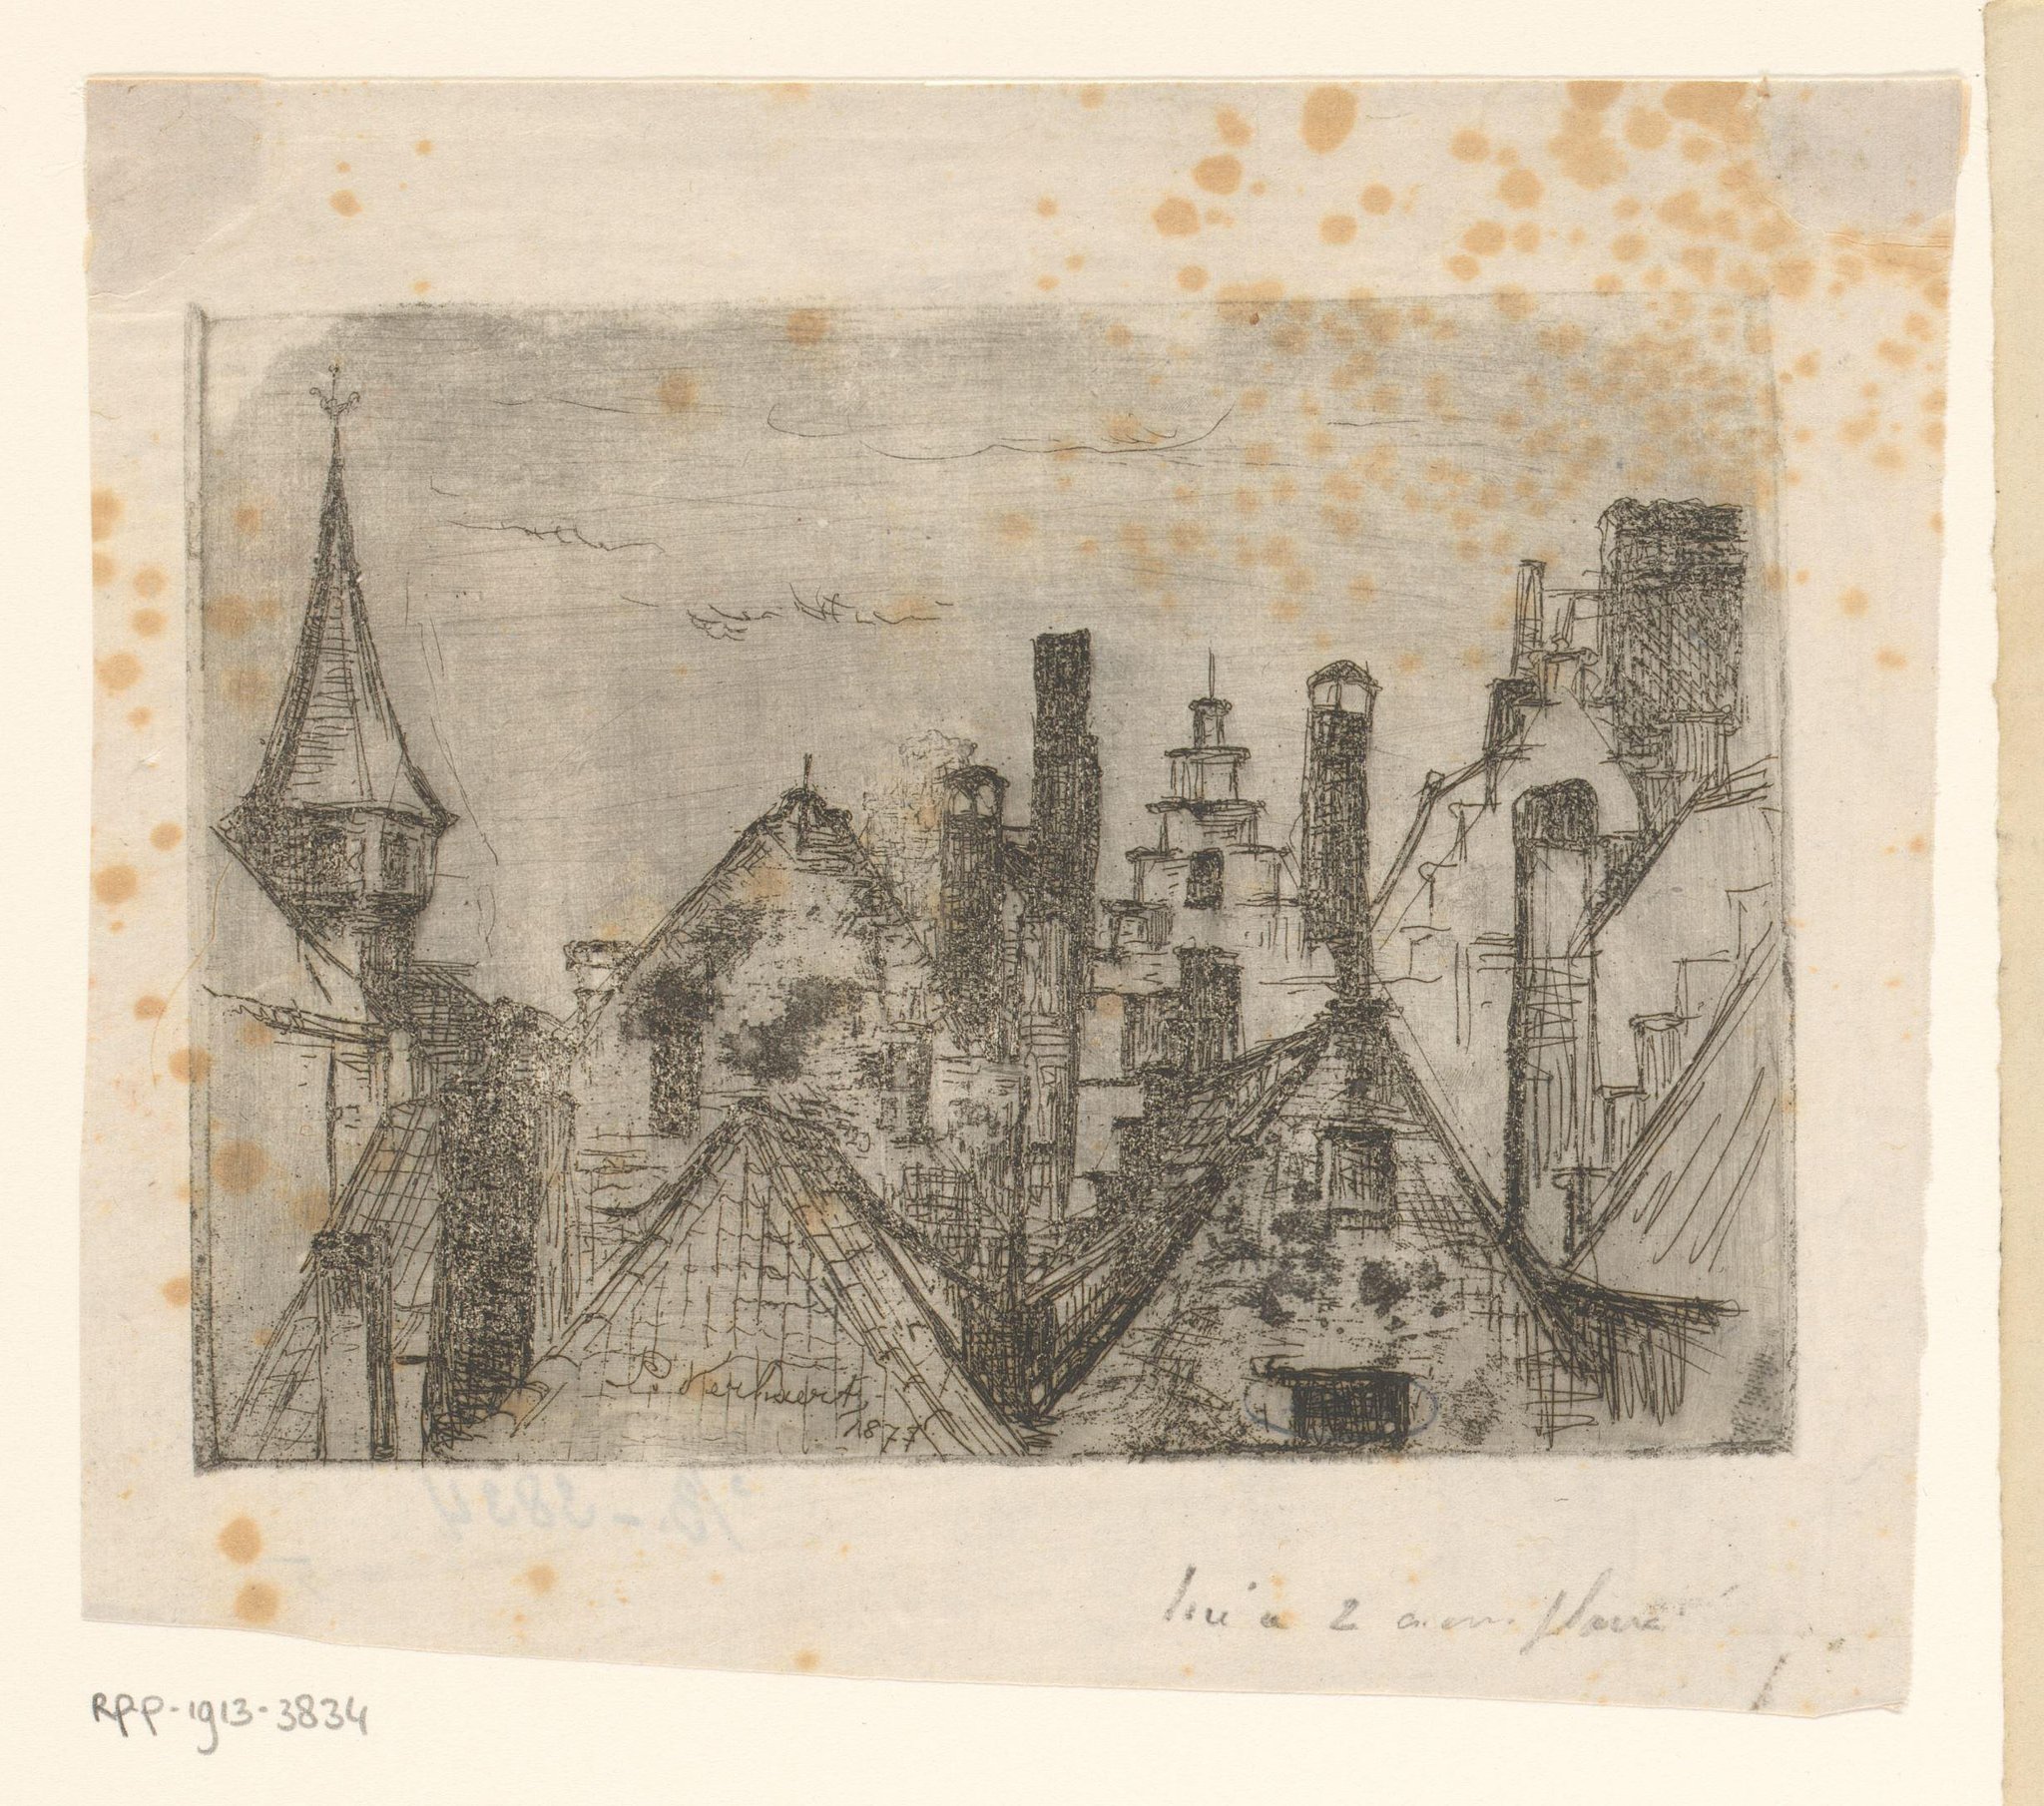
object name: print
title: Gezicht op verschillende daken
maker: piet verhaert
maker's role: print maker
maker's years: 1852-1908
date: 1877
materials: paper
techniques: etching, intaglio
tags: roof (of house or building), housing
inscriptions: collector's mark: Lugt 2228, inscription: ‘Tire a 2 exemplaire’